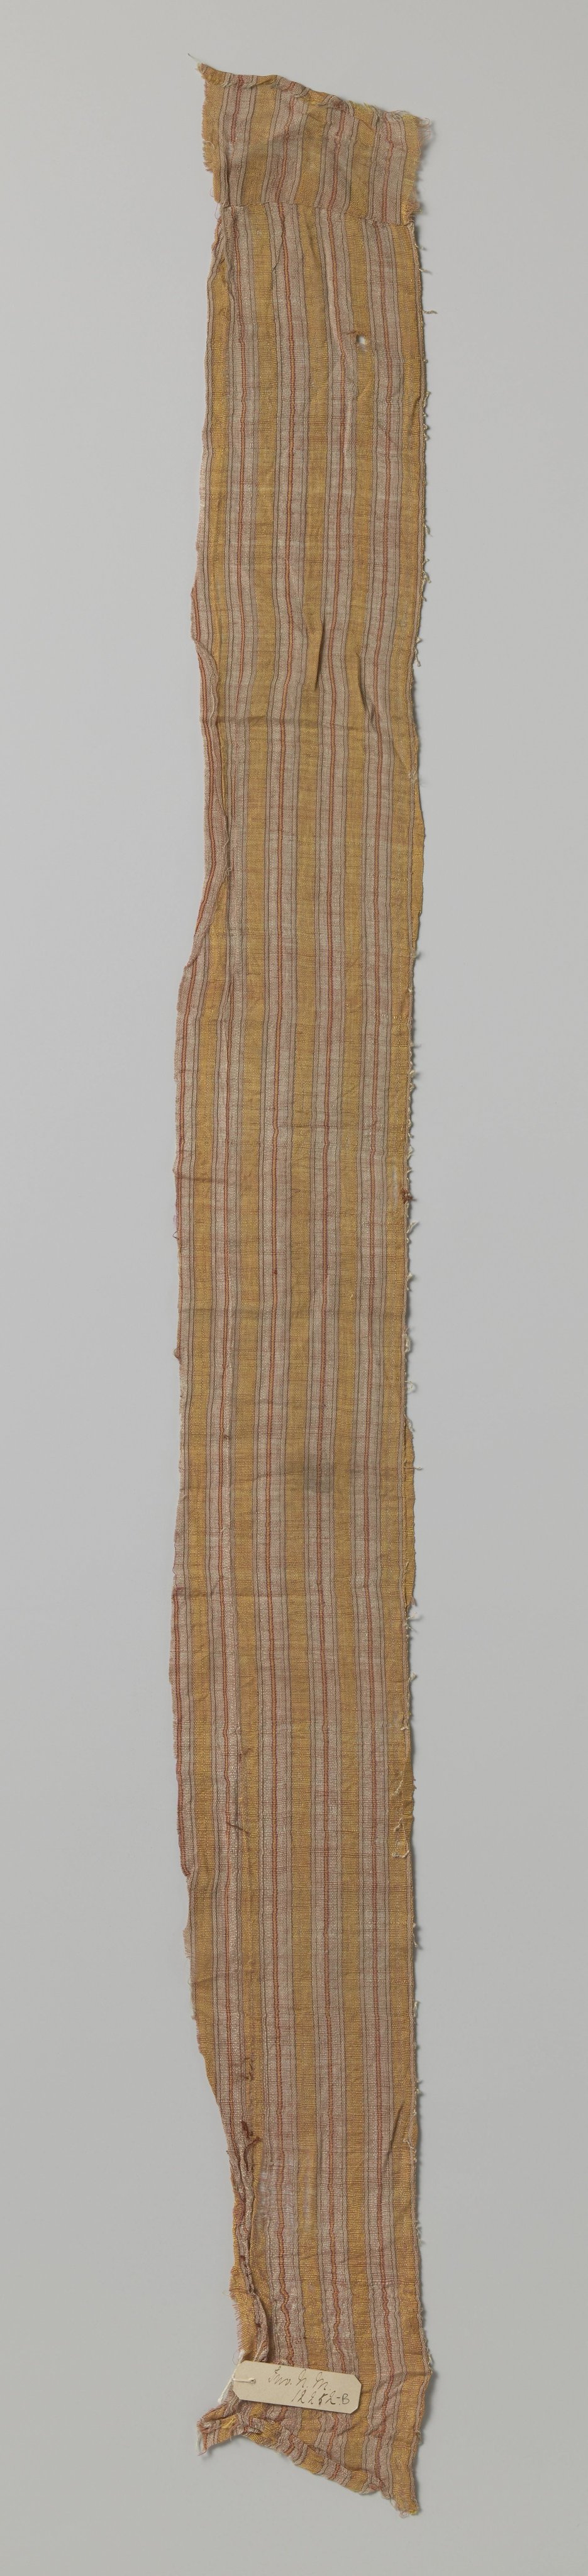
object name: silk textile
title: Fragment gestreept zijdeweefsel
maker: Anonymous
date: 1700-1799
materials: cotton, silk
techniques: weave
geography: europe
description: Fragment gestreept zijdeweefsel in oranje en wit.